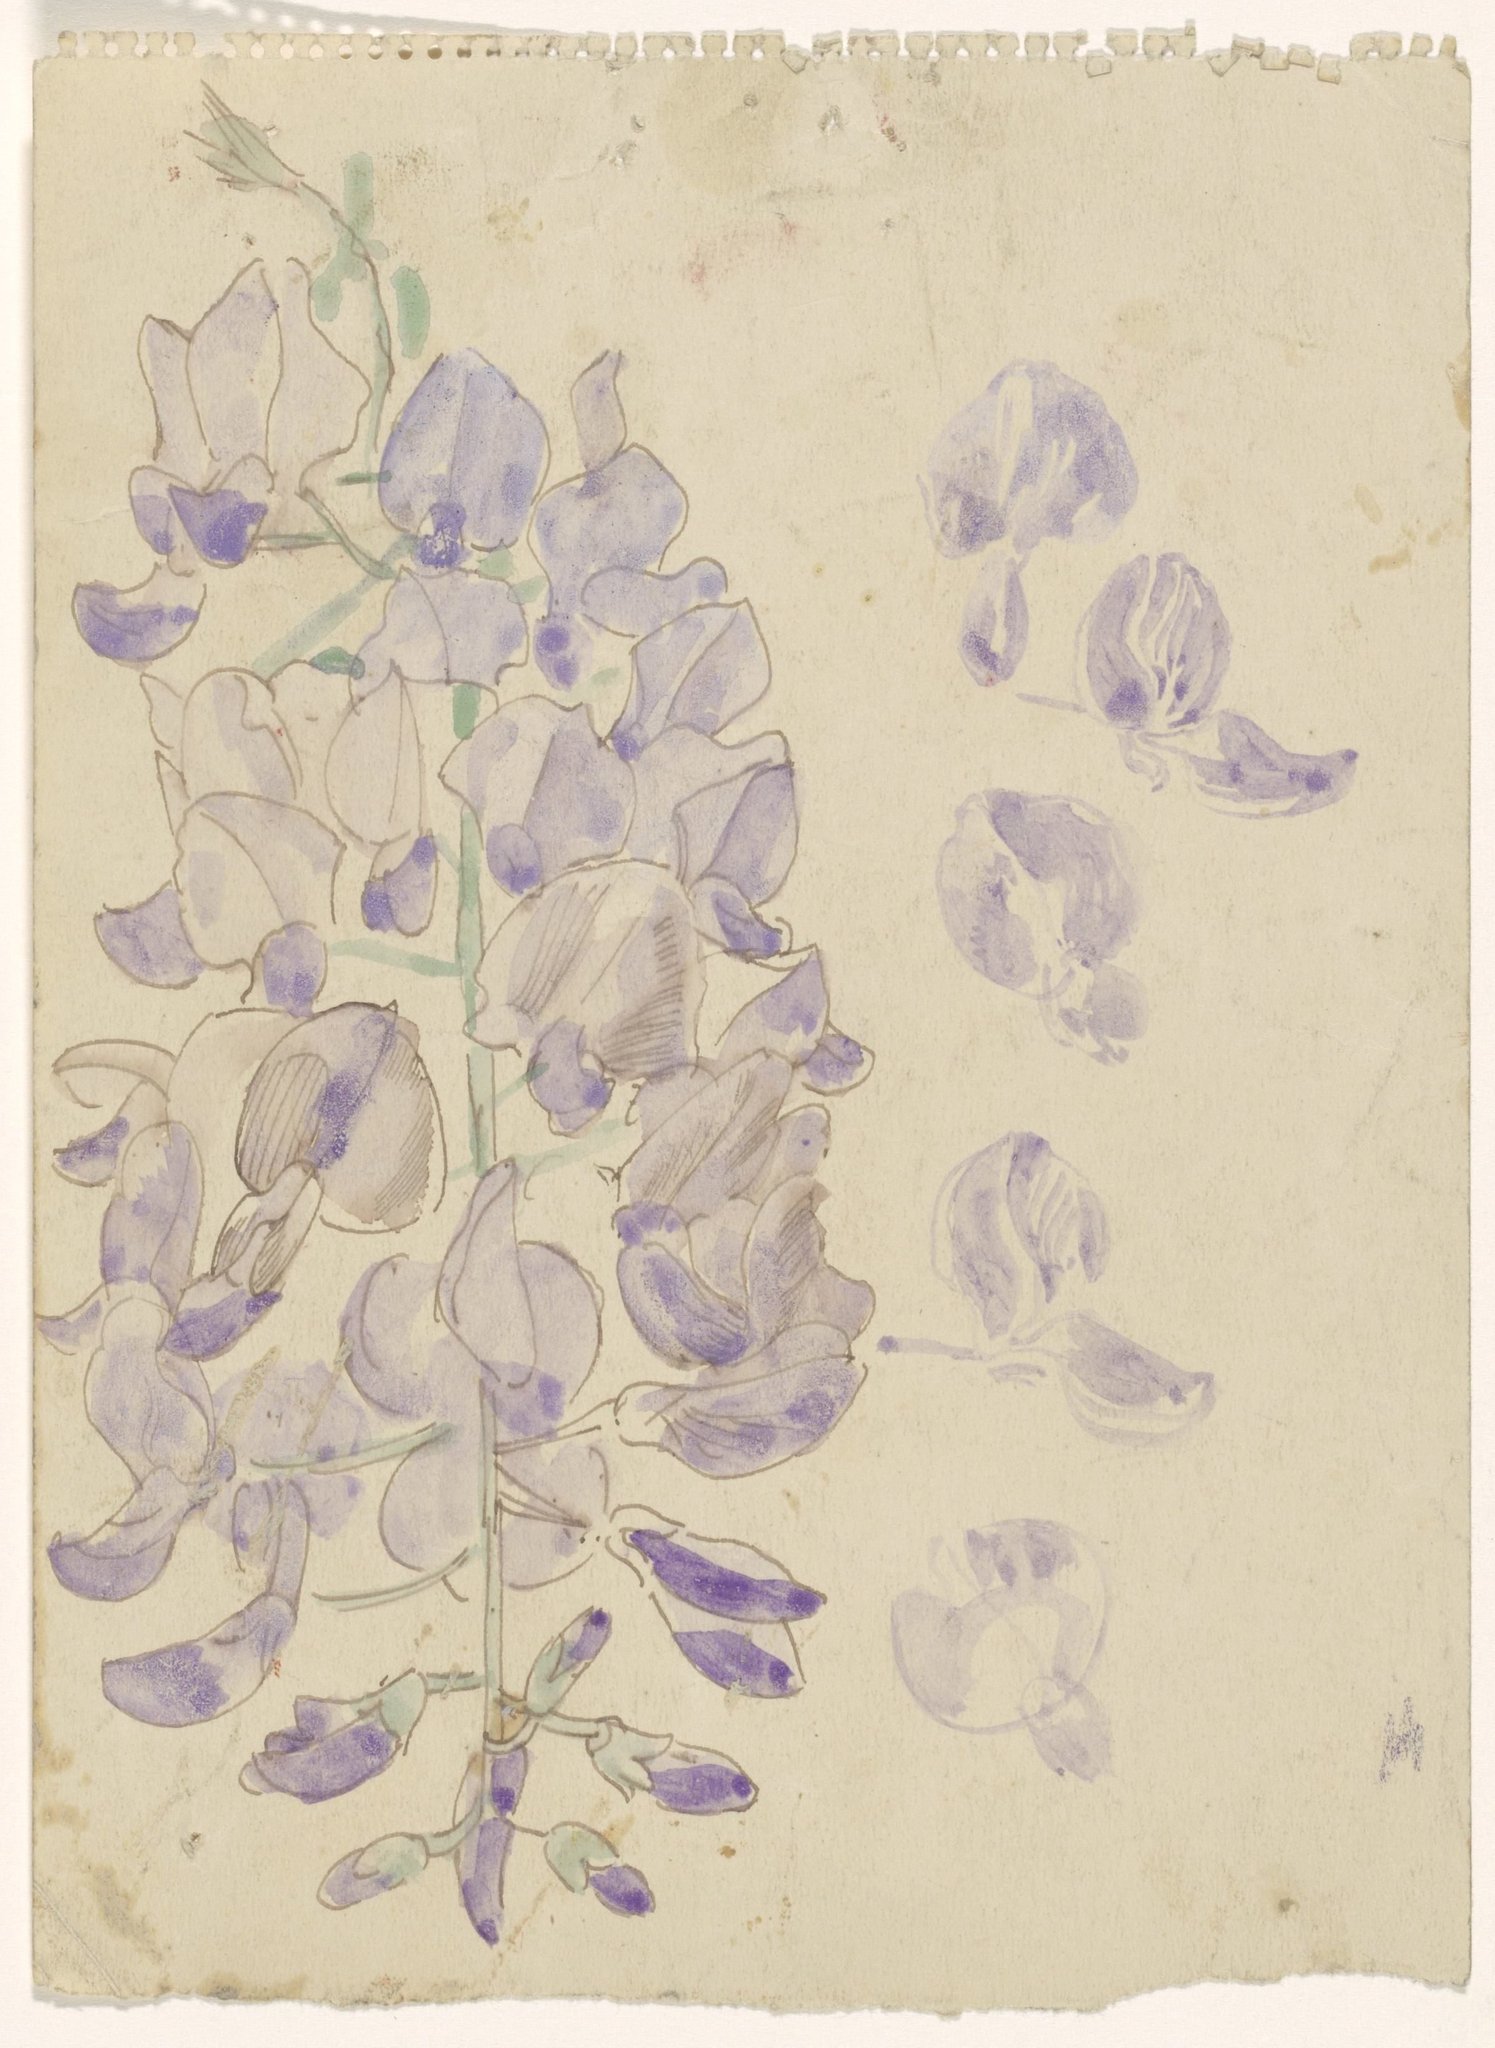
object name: drawing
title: Wisteria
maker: carel adolph lion cachet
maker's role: draughtsman, print maker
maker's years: 1864-1945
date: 1874-1945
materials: ink, paper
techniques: brush, pen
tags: flowers: lupin